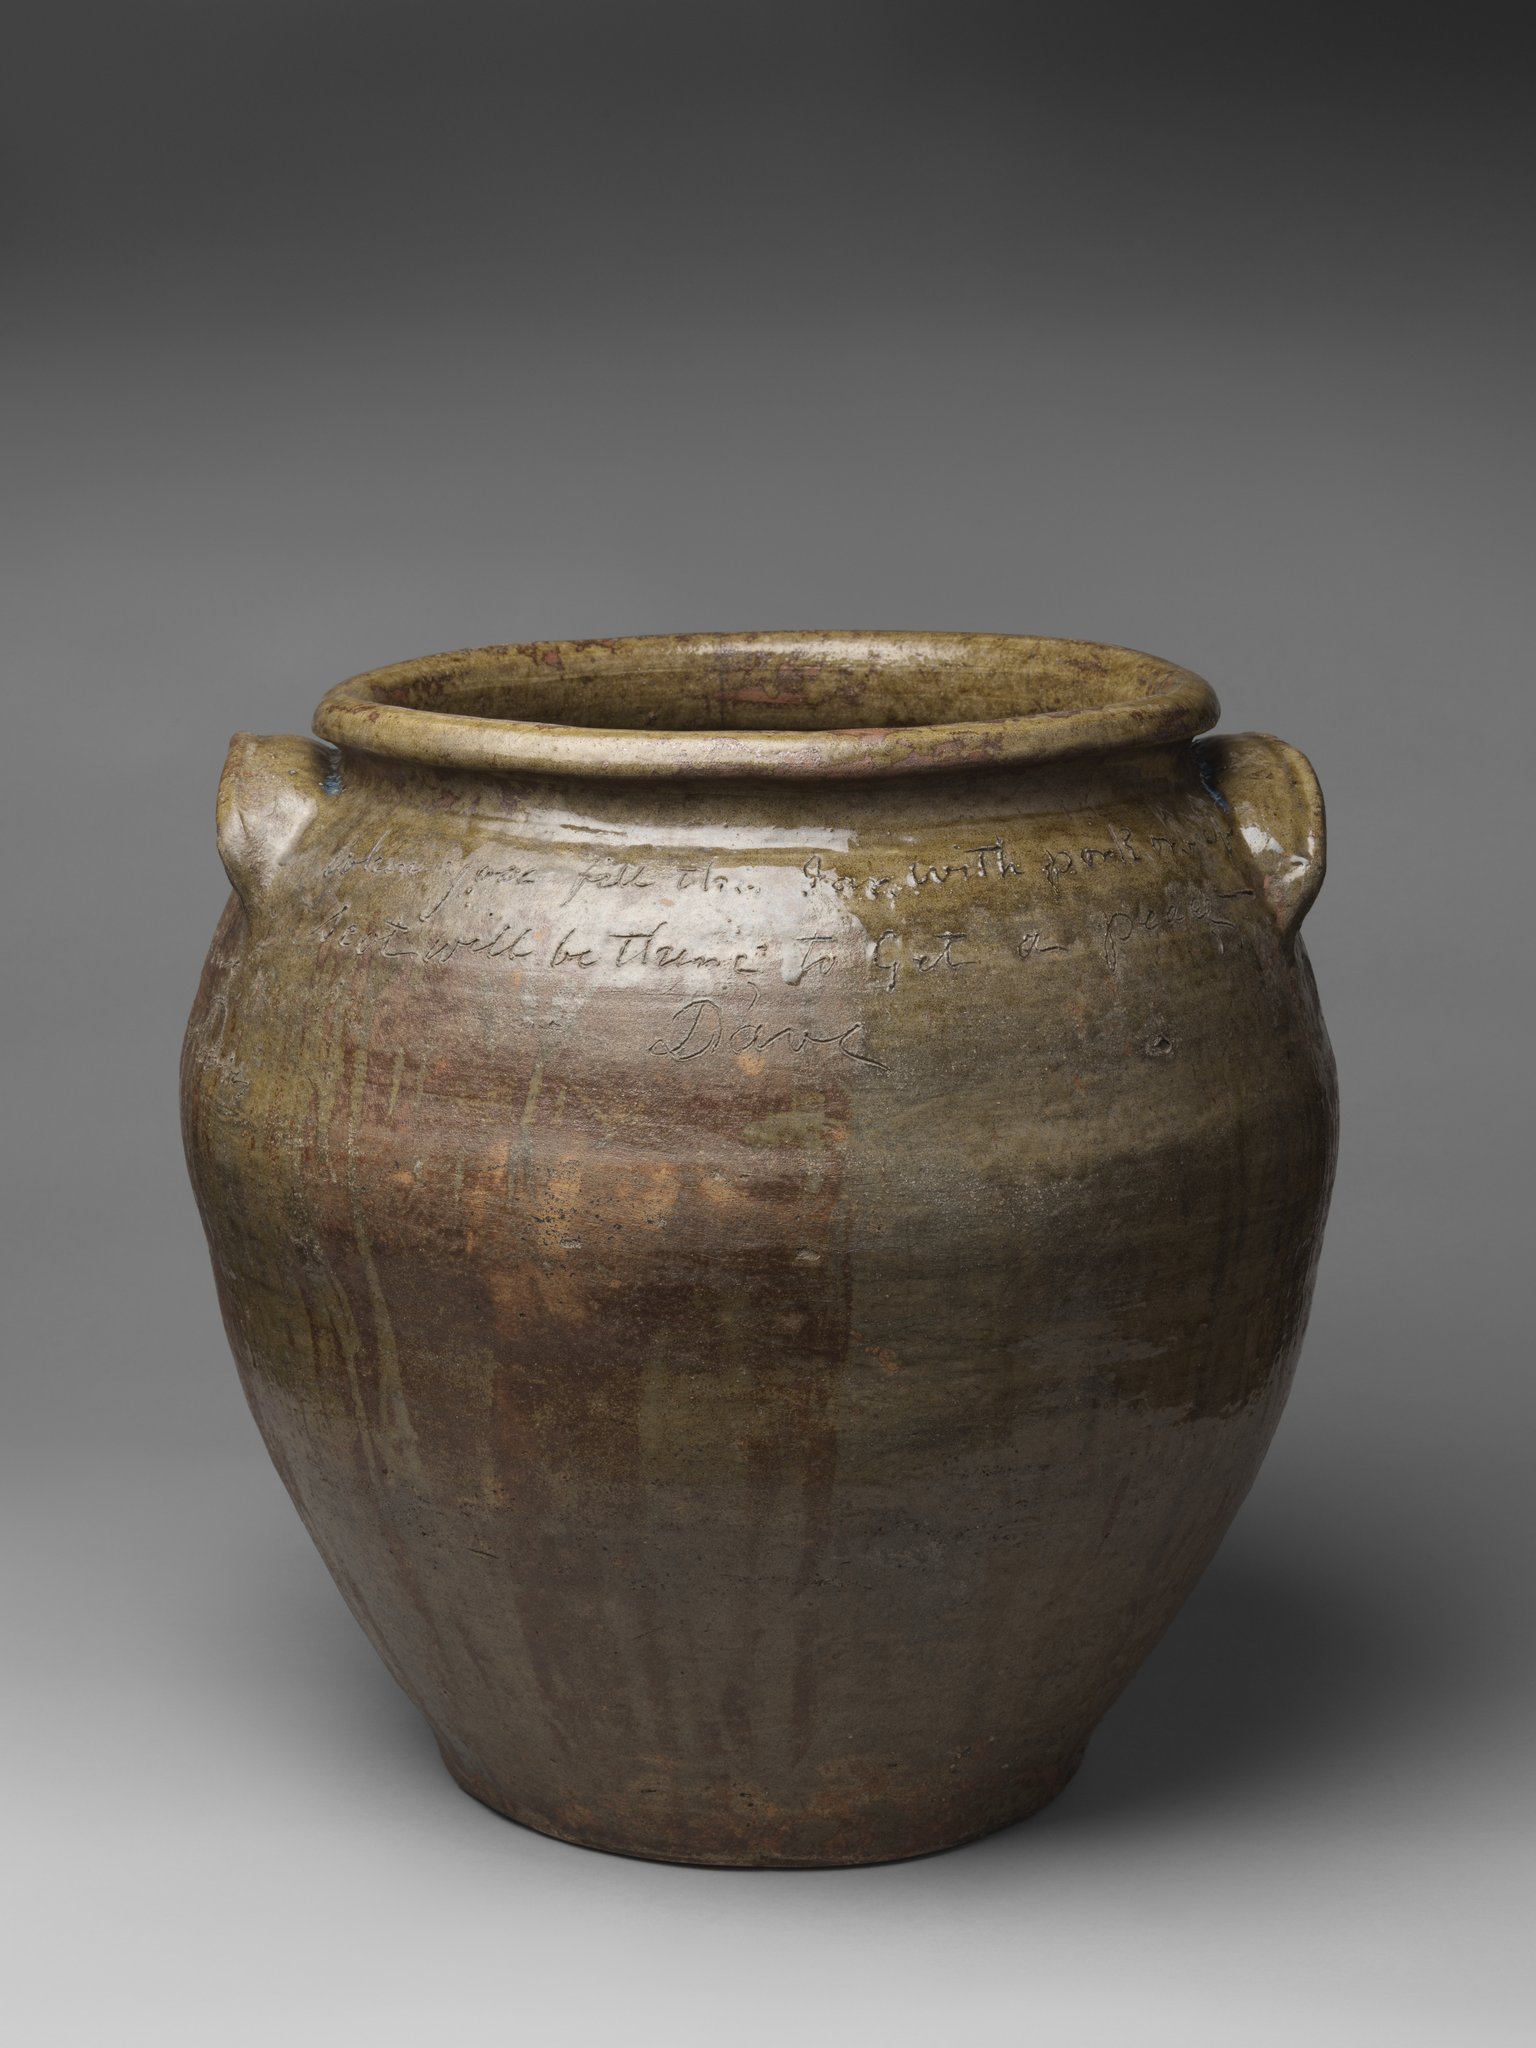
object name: storage jar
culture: american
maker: dave (later recorded as david drake)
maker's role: maker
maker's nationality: american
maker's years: 1801-1870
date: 1858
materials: stoneware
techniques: glazing